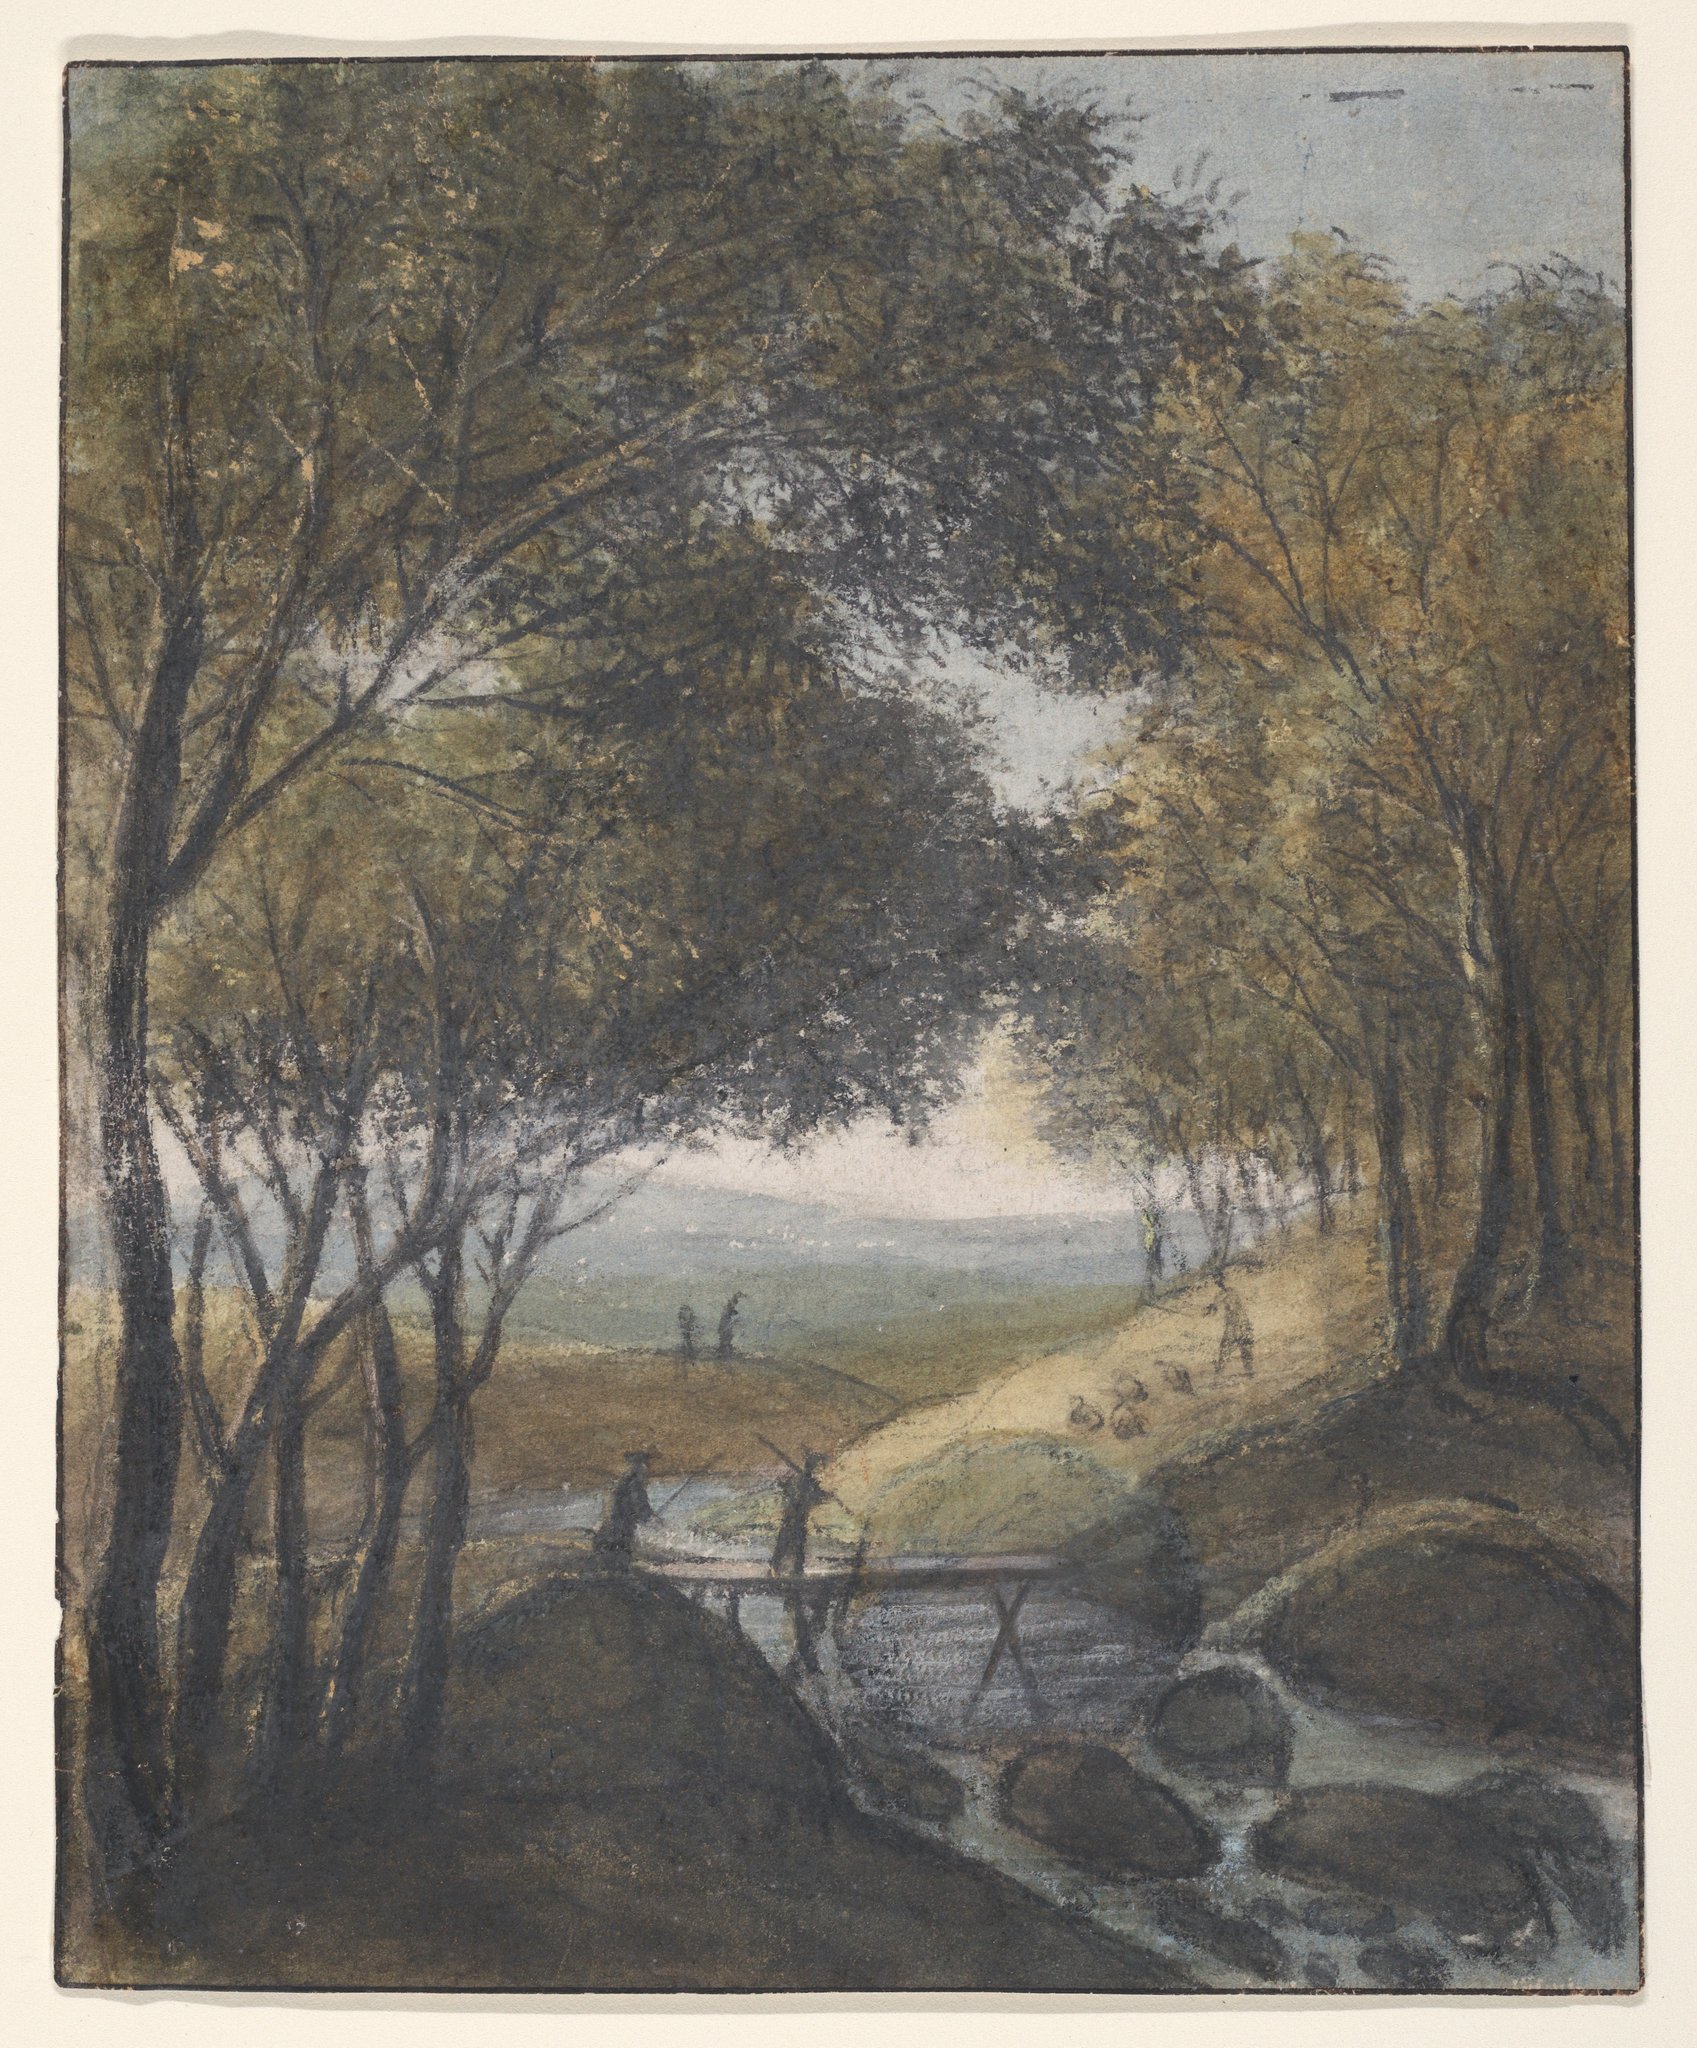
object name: drawing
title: Landscape with a Traveler Crossing a Bridge (recto); Sketches of a Gate, a Bridge, and a Town Hall (verso)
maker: anthonie waterloo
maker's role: artist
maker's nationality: dutch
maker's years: 1609-1690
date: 1629-1690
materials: chalk, gouache, ink, watercolor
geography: netherlands